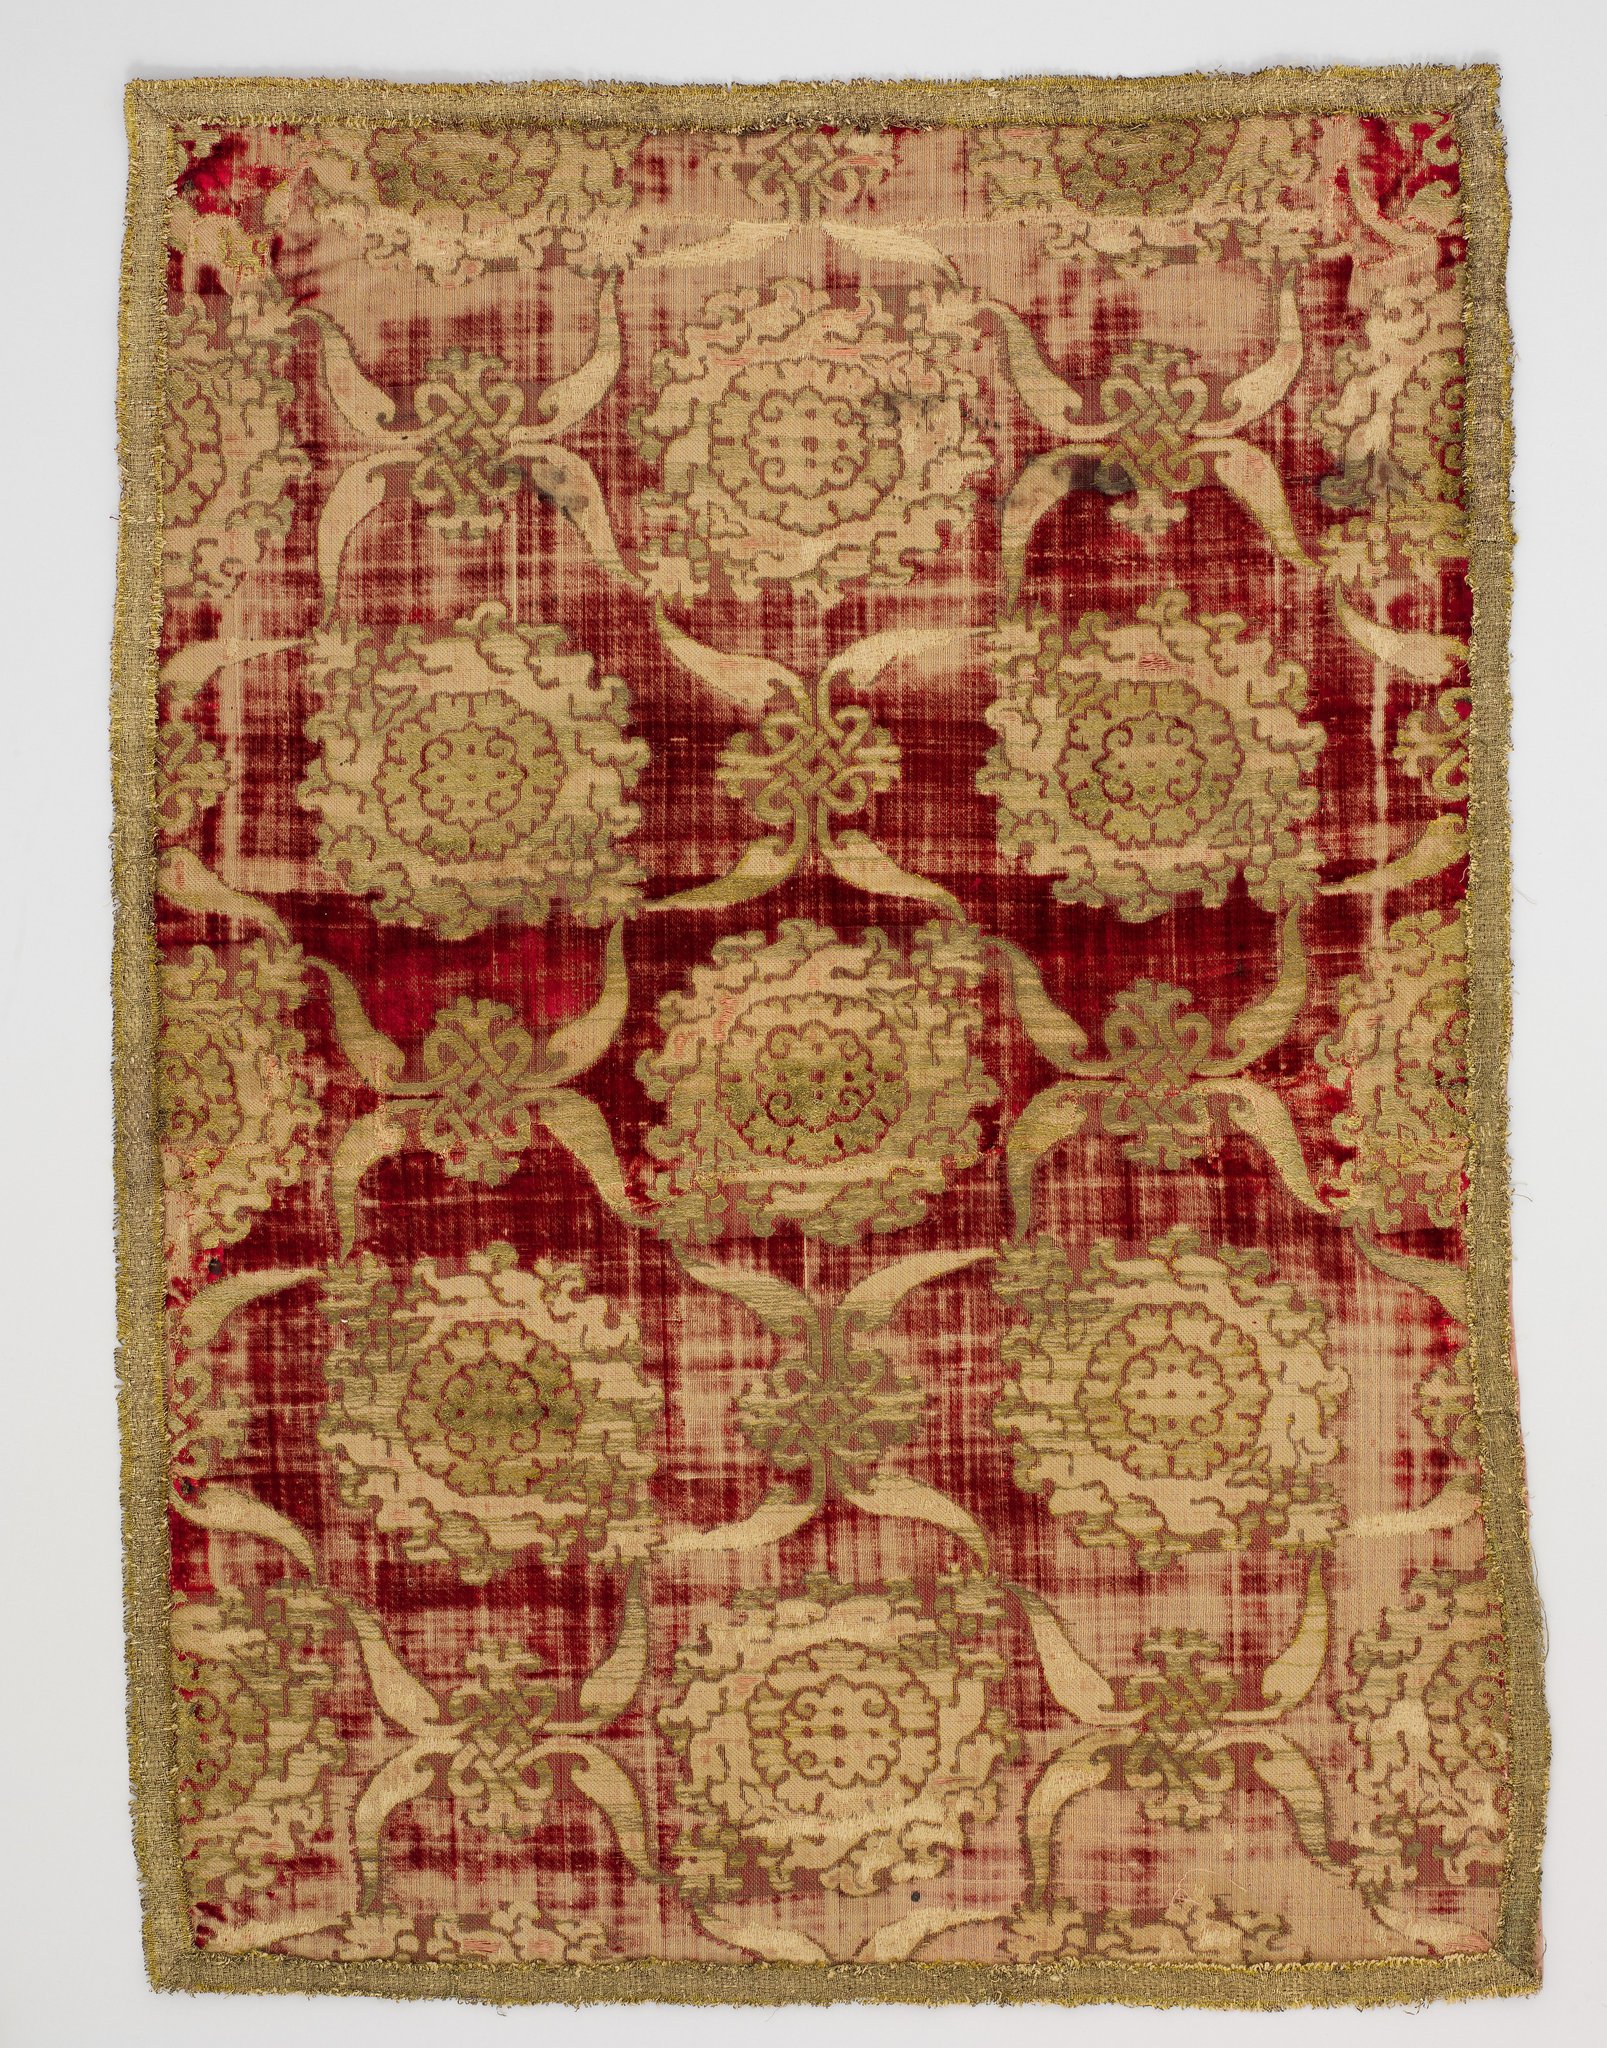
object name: piece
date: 1460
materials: metal thread, silk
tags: flowers